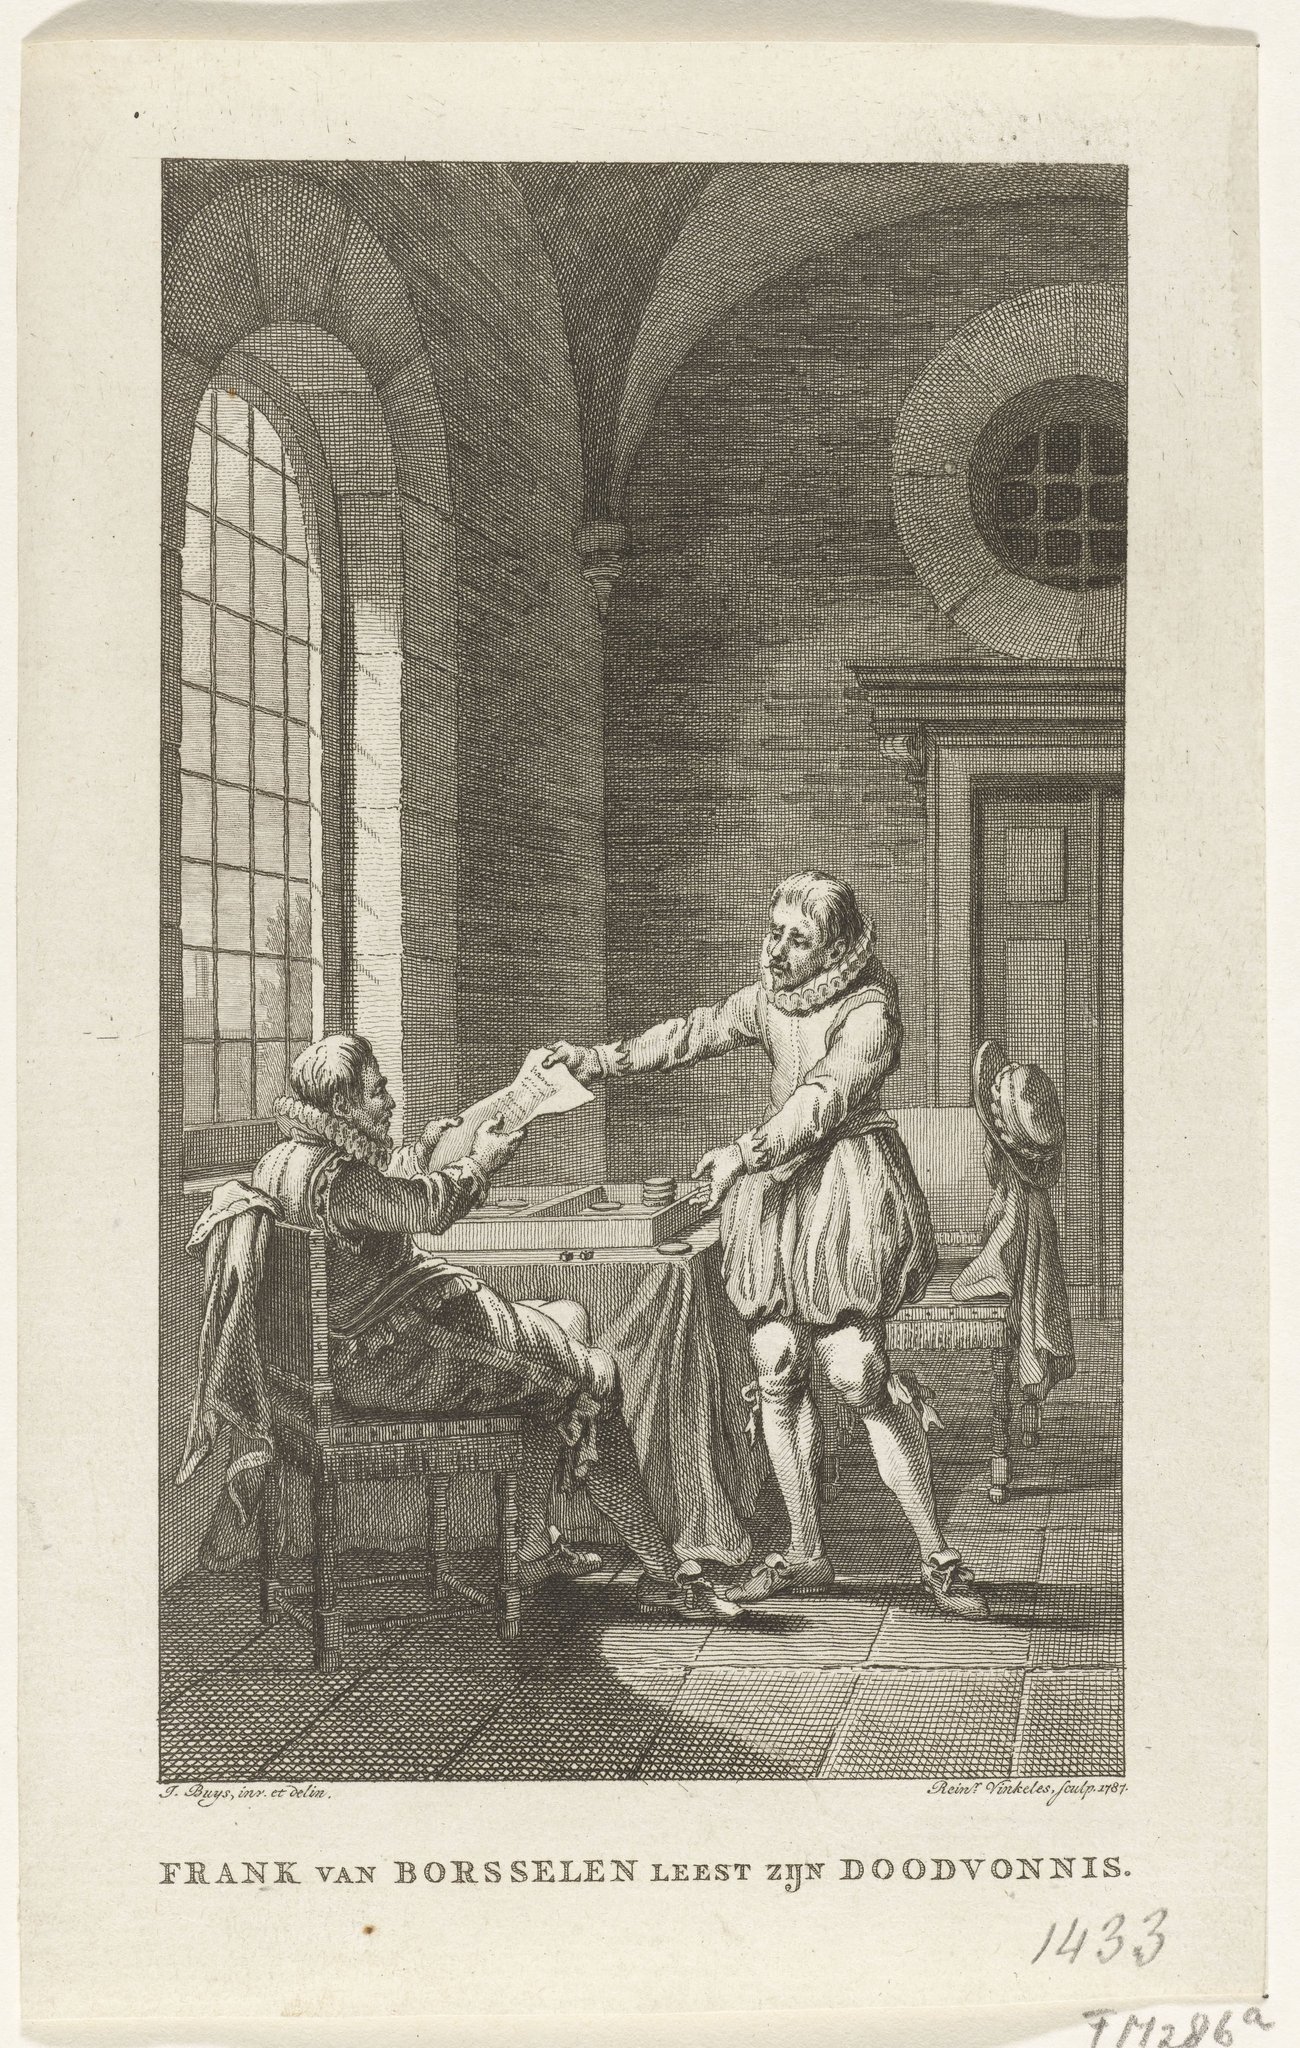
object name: history print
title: Frank van Borselen krijgt zijn doodsvonnis, 1433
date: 1787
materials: paper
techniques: etching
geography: netherlands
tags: bruges, philip iii the good, jacoba of bavaria (countess of hainaut), brielle, ordering the execution of a verdict, burgundian netherlands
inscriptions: date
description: Frank van Borselen wordt na zijn geheime huwelijk met Jacoba van Beieren door Filips de Goede op het slot Rupelmonde gevangen gezet. Hier krijgt hij tijdens een bordspel met de slotvoogd zijn doodsvonnis overhandigd, 1433.